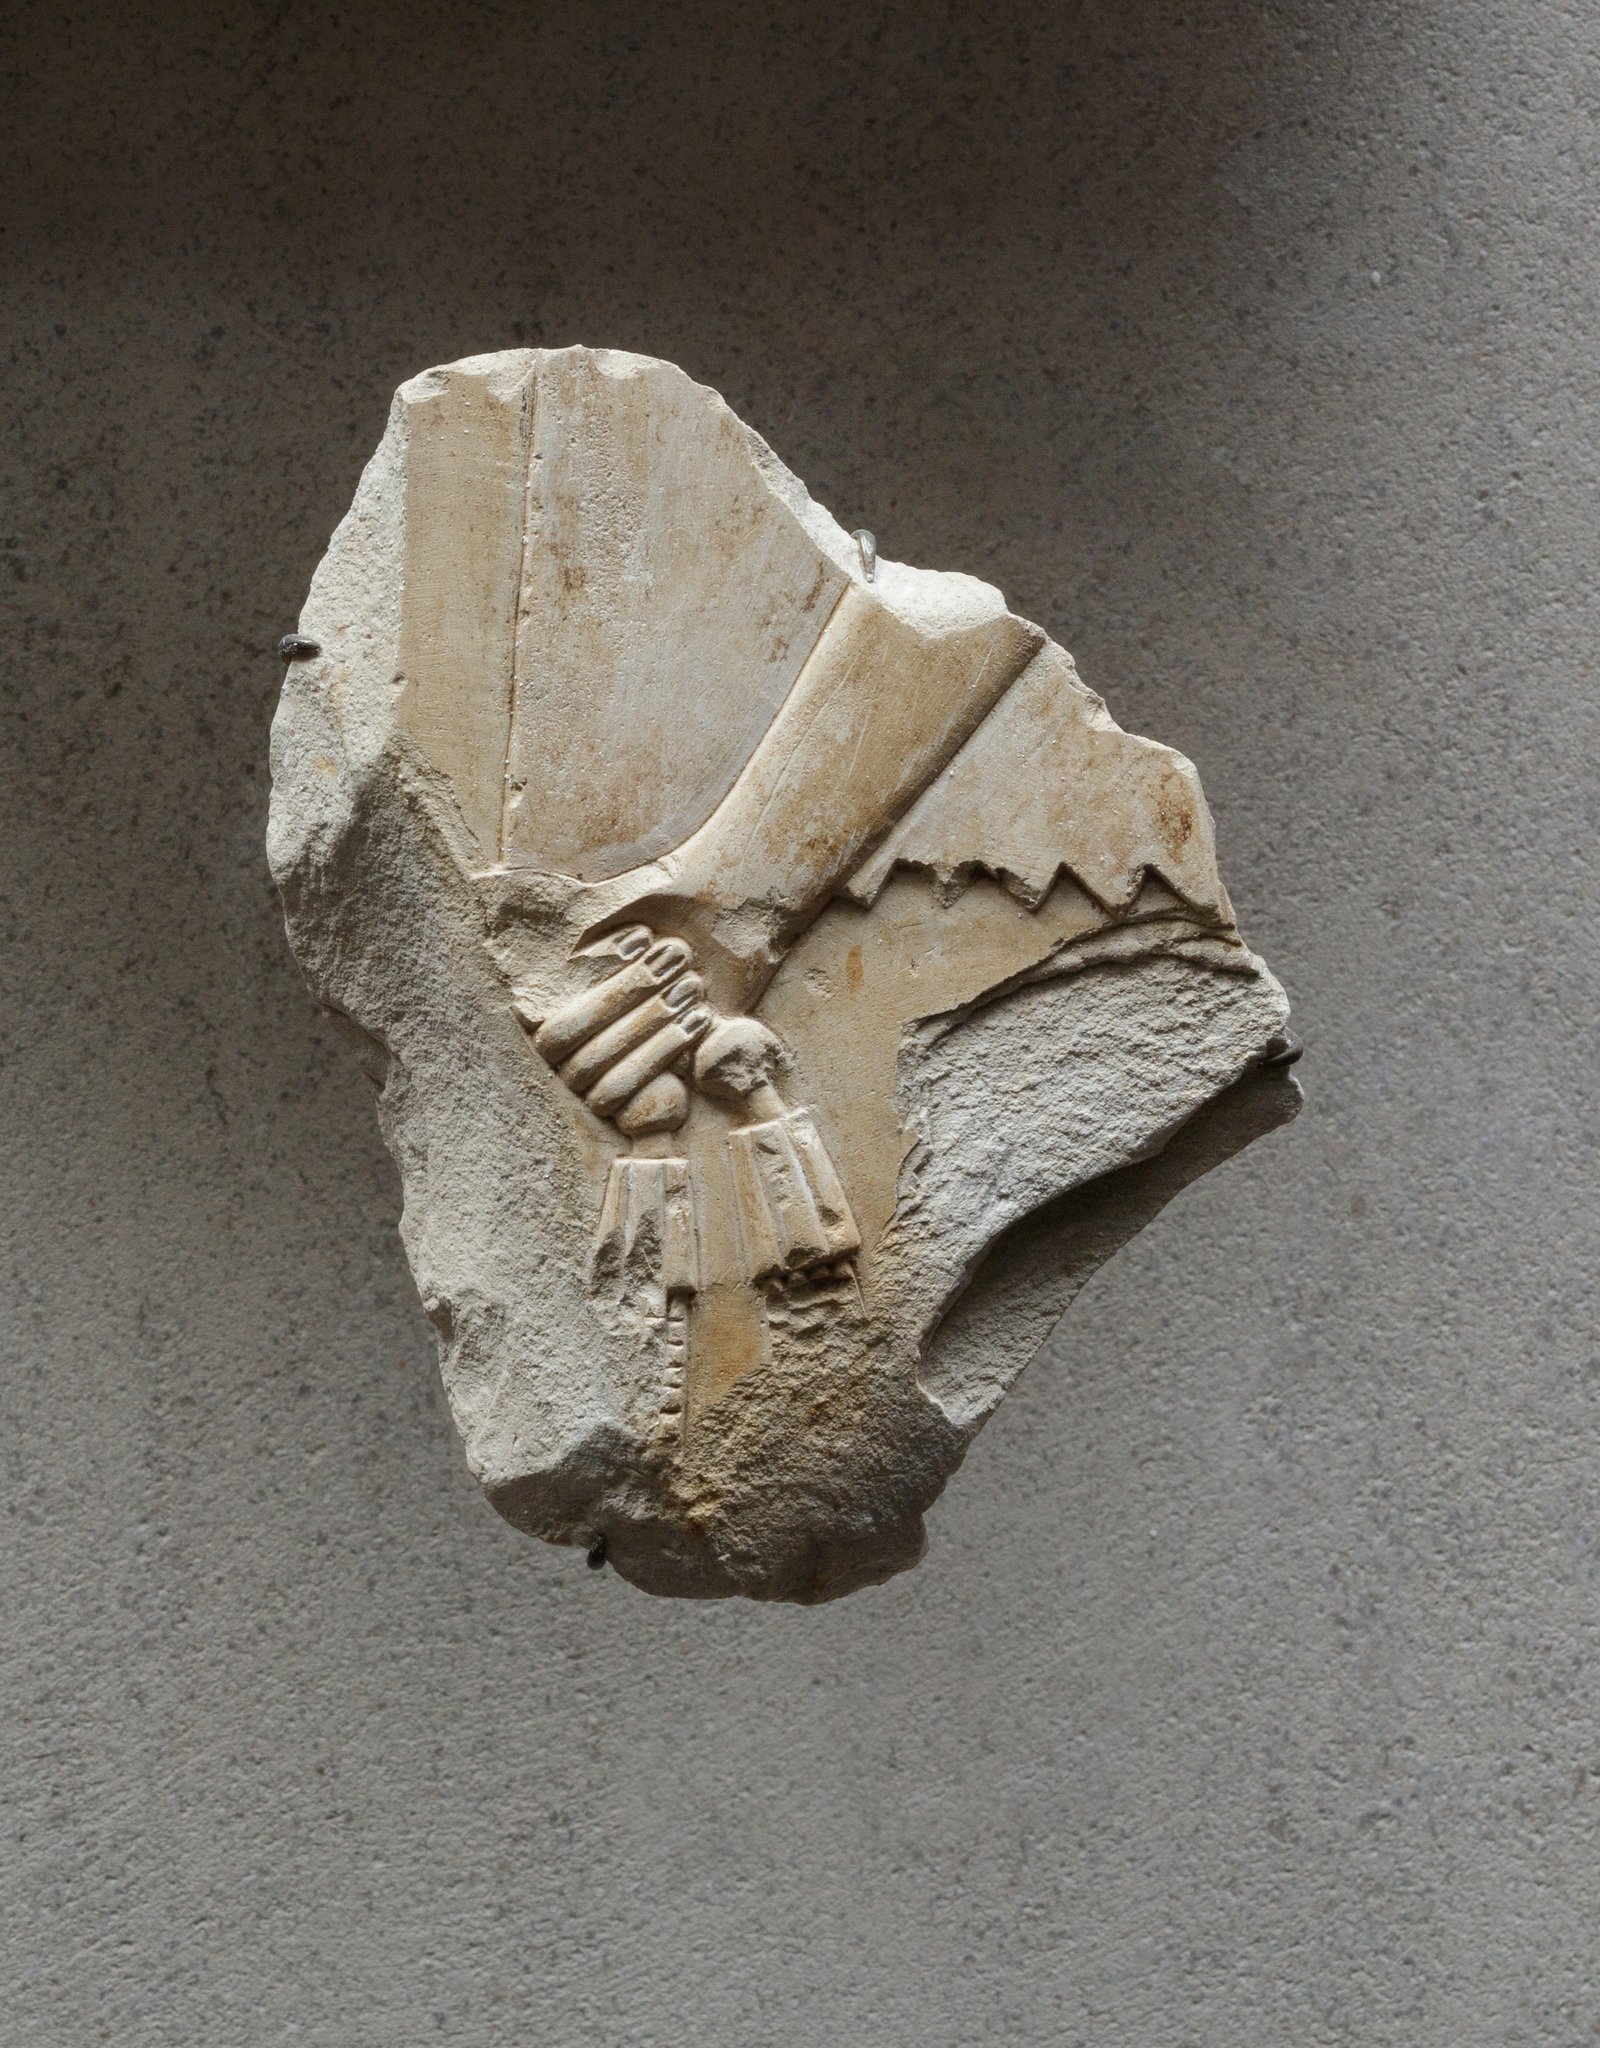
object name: relief, attendant's hand holding necklace, neferu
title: Relief of an attendant's hand holding a necklace - see 26.3.353-3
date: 2051-2030 BCE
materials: limestone, paint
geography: egypt